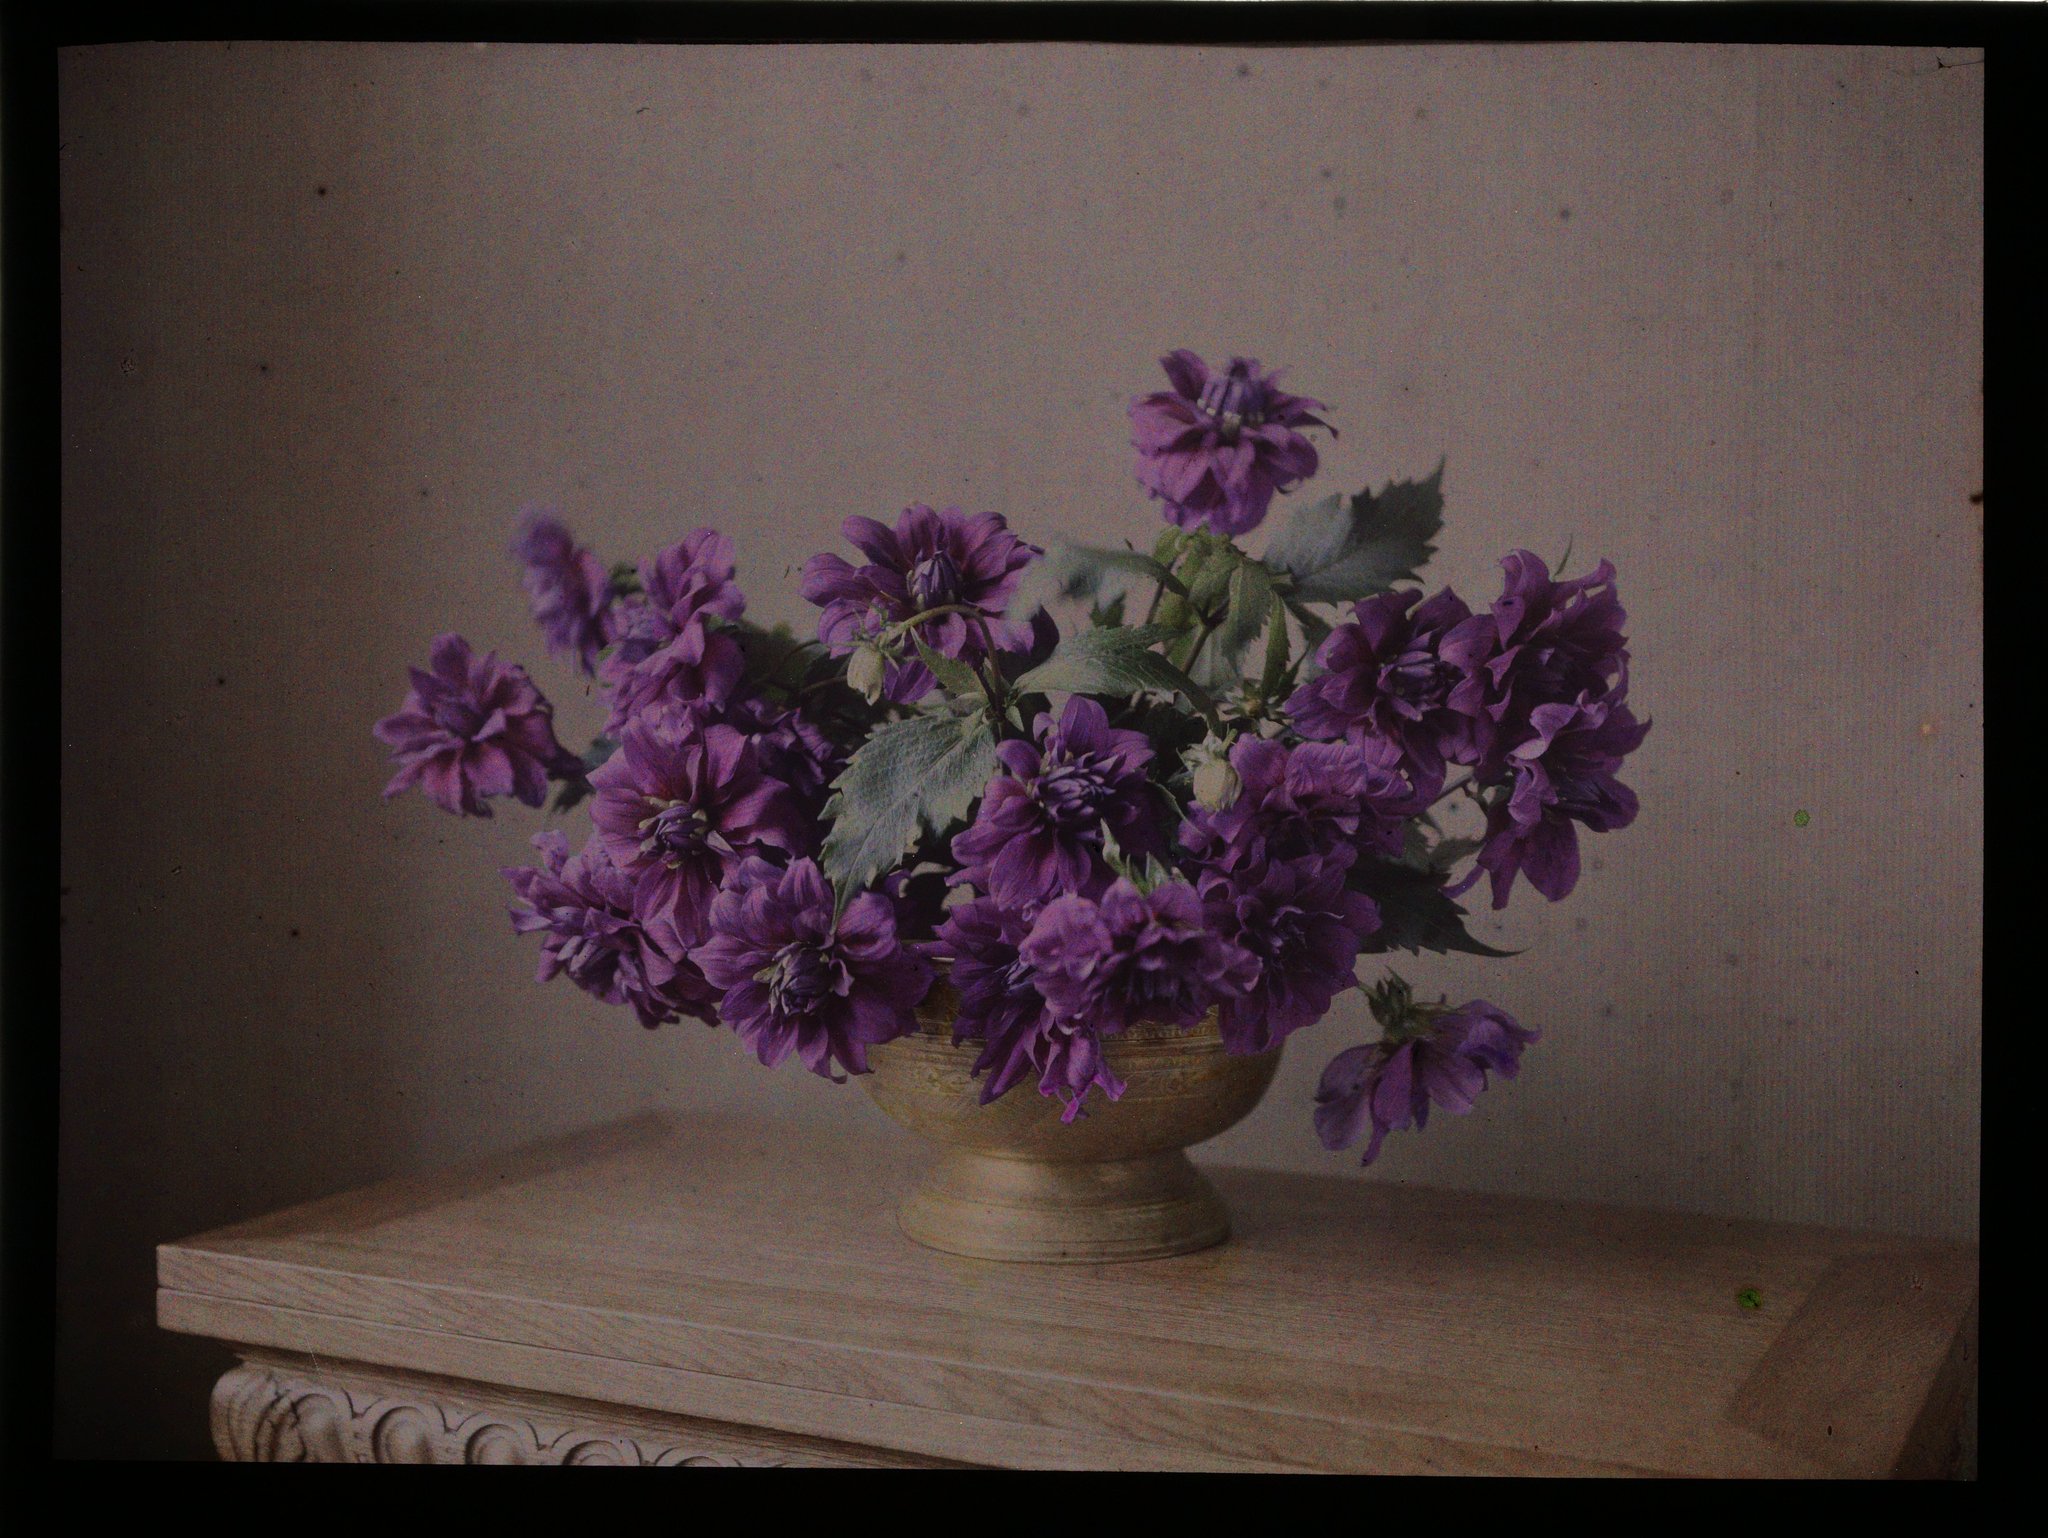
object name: photograph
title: Bloemstuk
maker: Anonymous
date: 1907-1935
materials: glass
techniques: autochrome process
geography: netherlands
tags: cut flowers; nosegay, bunch of flowers, flowers in a vase, netherlands